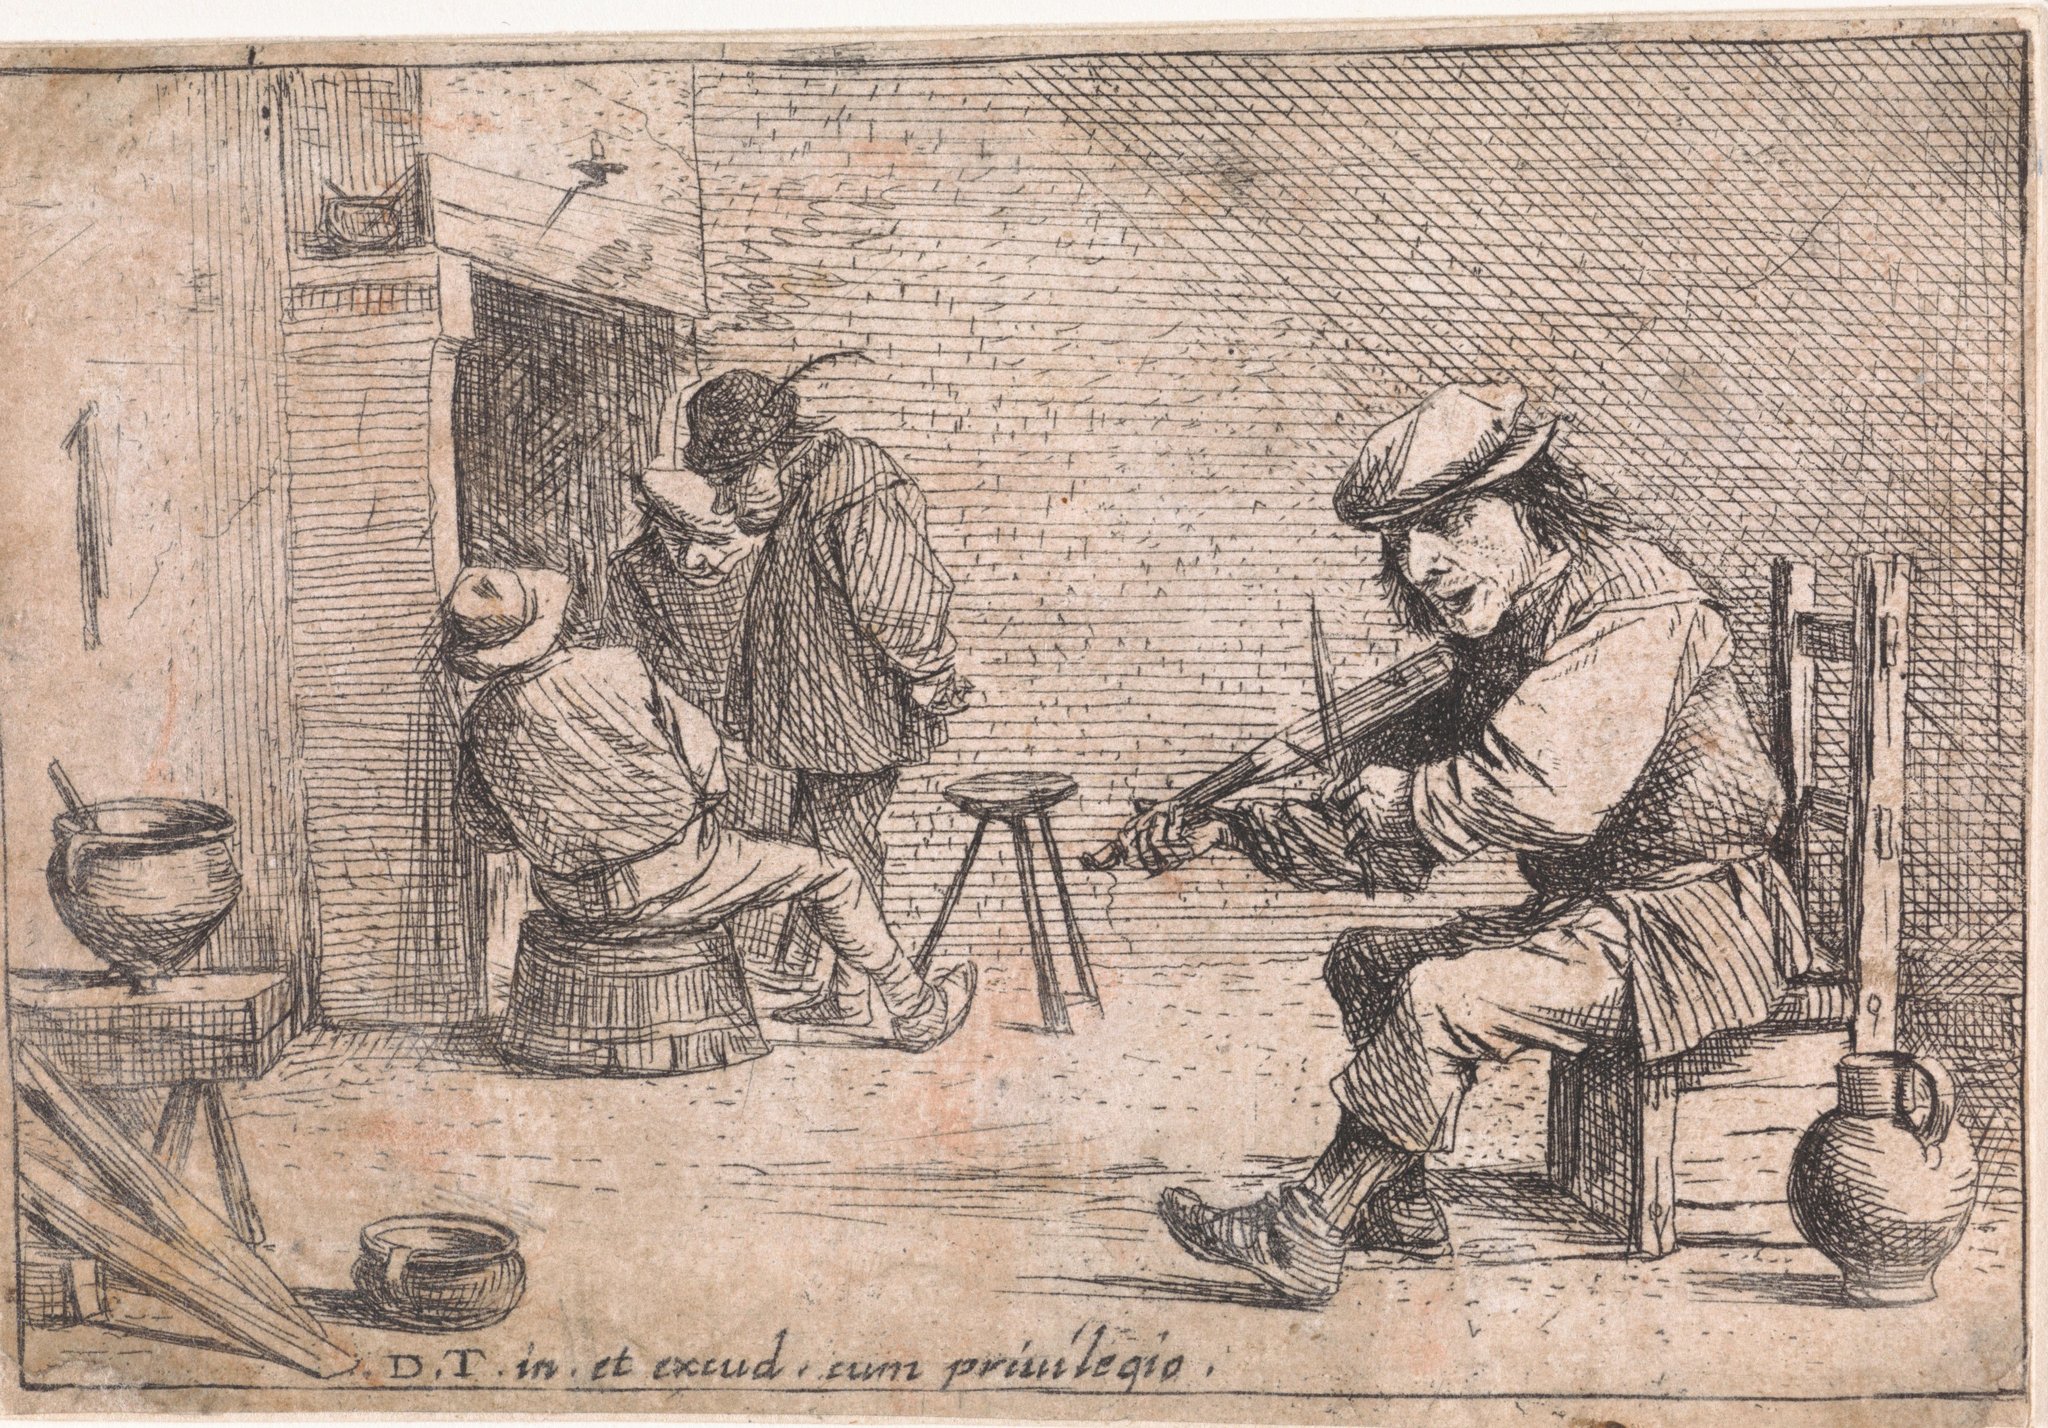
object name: print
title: Vioolspelende boer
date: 1626-1690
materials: paper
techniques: etching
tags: violin, fiddle, open hearth, fire-place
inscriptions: collector's mark: Lugt 2228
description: Een boer bespeelt de viool. Links drie mannen bij de haard.